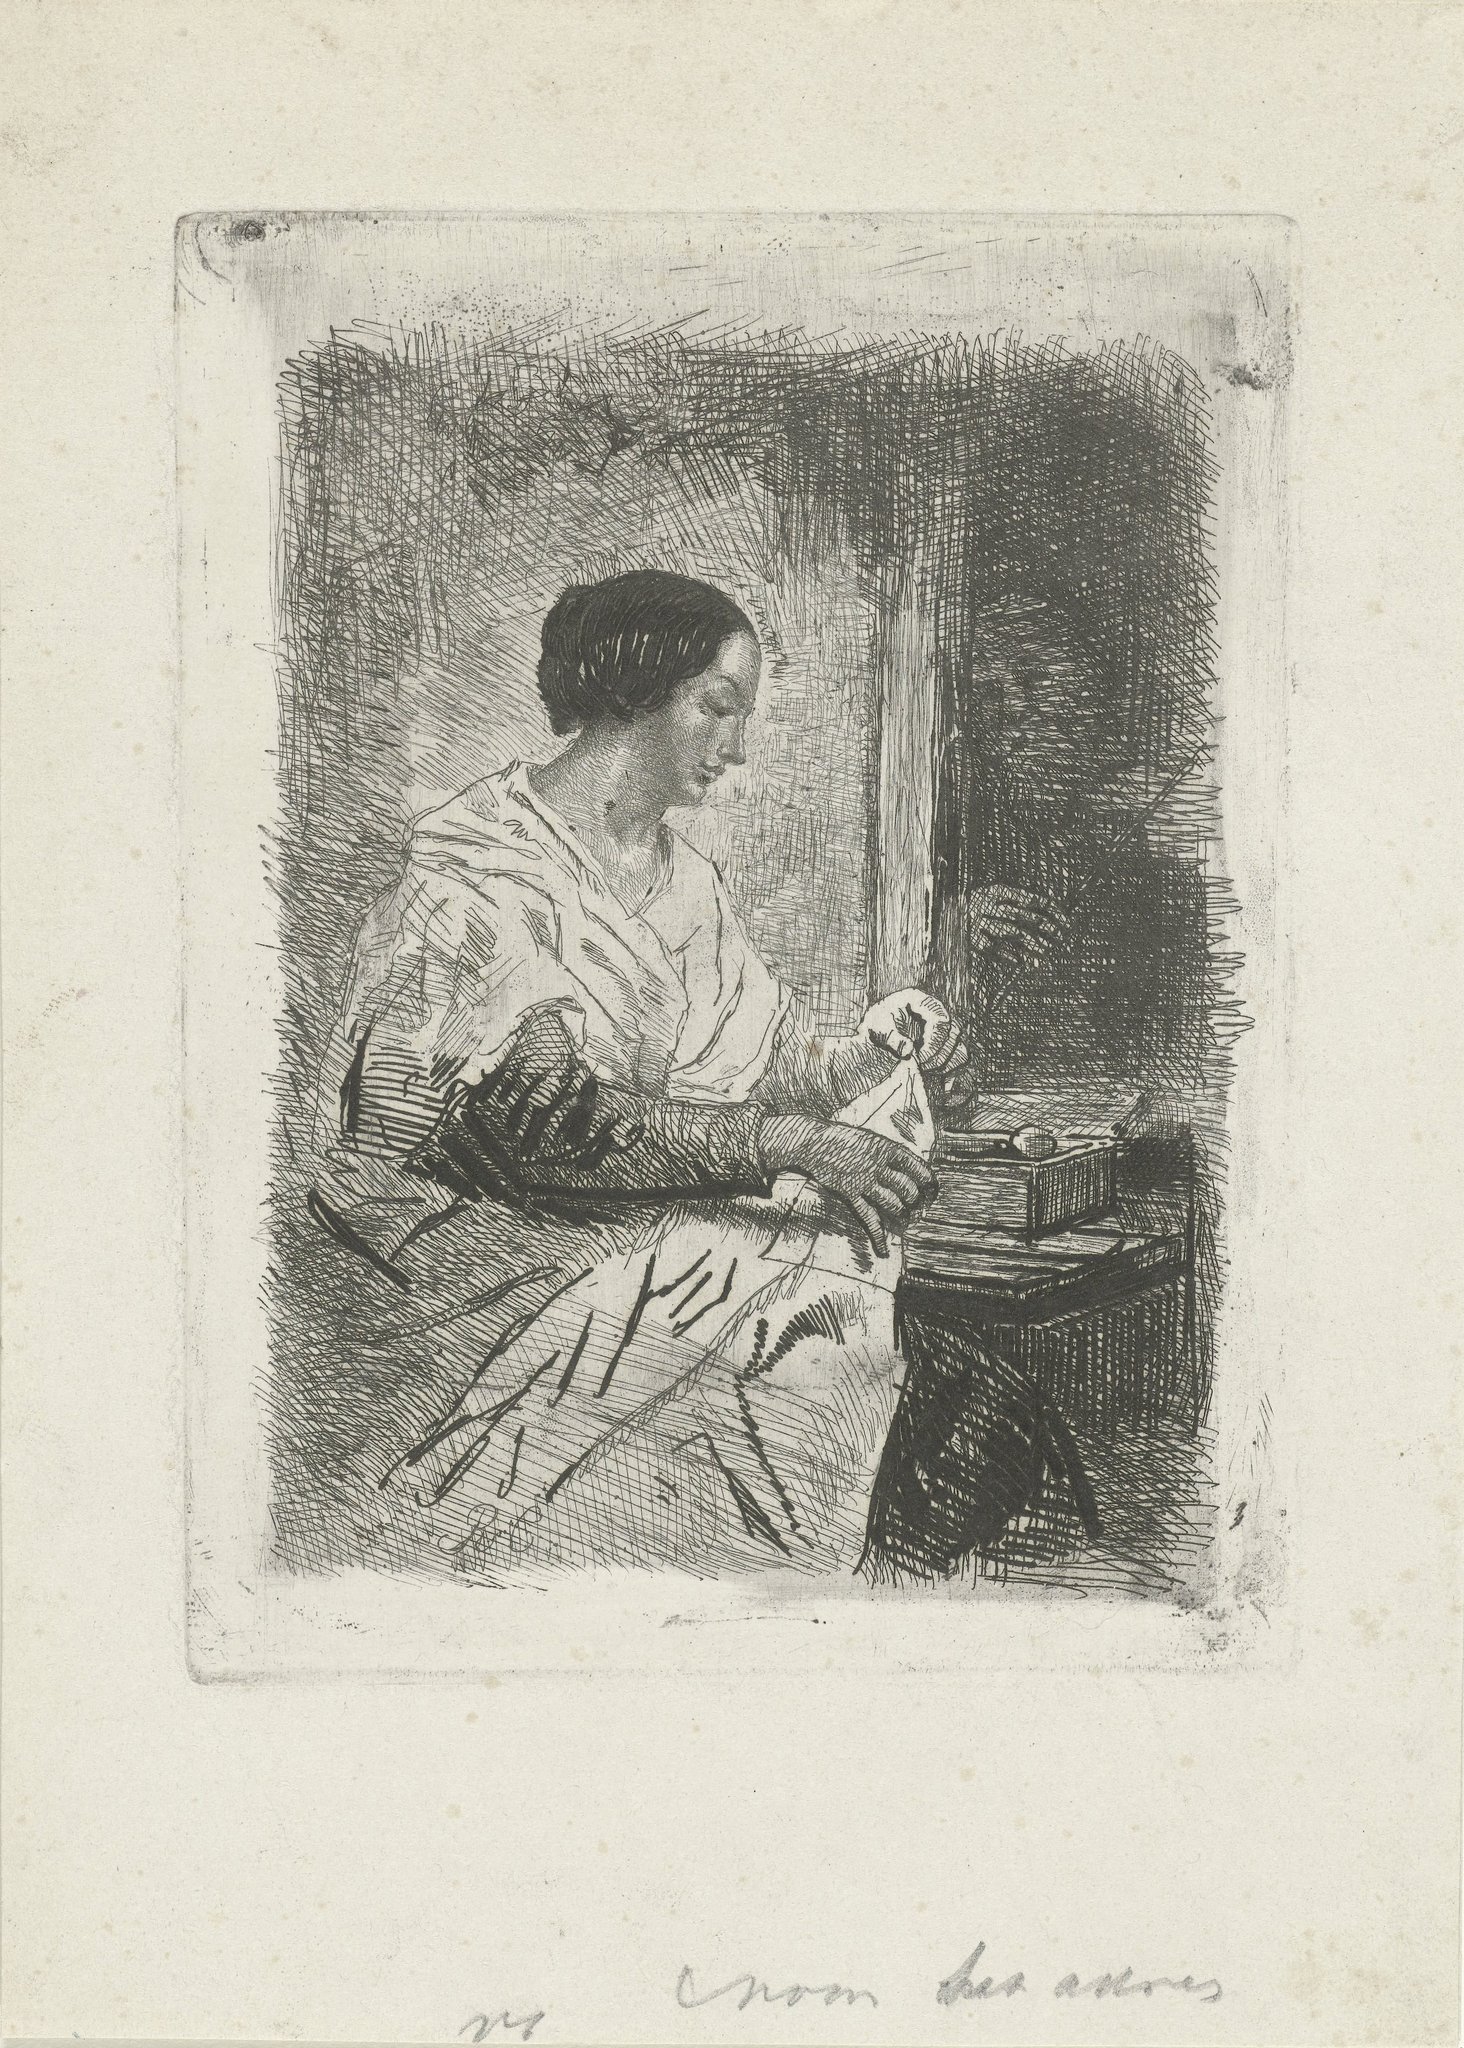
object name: print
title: Naaister en vioolspeler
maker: reinier craeyvanger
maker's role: draughtsman, print maker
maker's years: 1812-1880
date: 1822-1880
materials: paper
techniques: etching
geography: amsterdam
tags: one person playing string instrument (bowed), violin, fiddle, sewing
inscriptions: collector's mark: Lugt 2228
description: Een vrouw zit op een bankje en gebruikt naald en draad om een laken te verstellen. In de deuropening achter haar speelt een oude man viool.